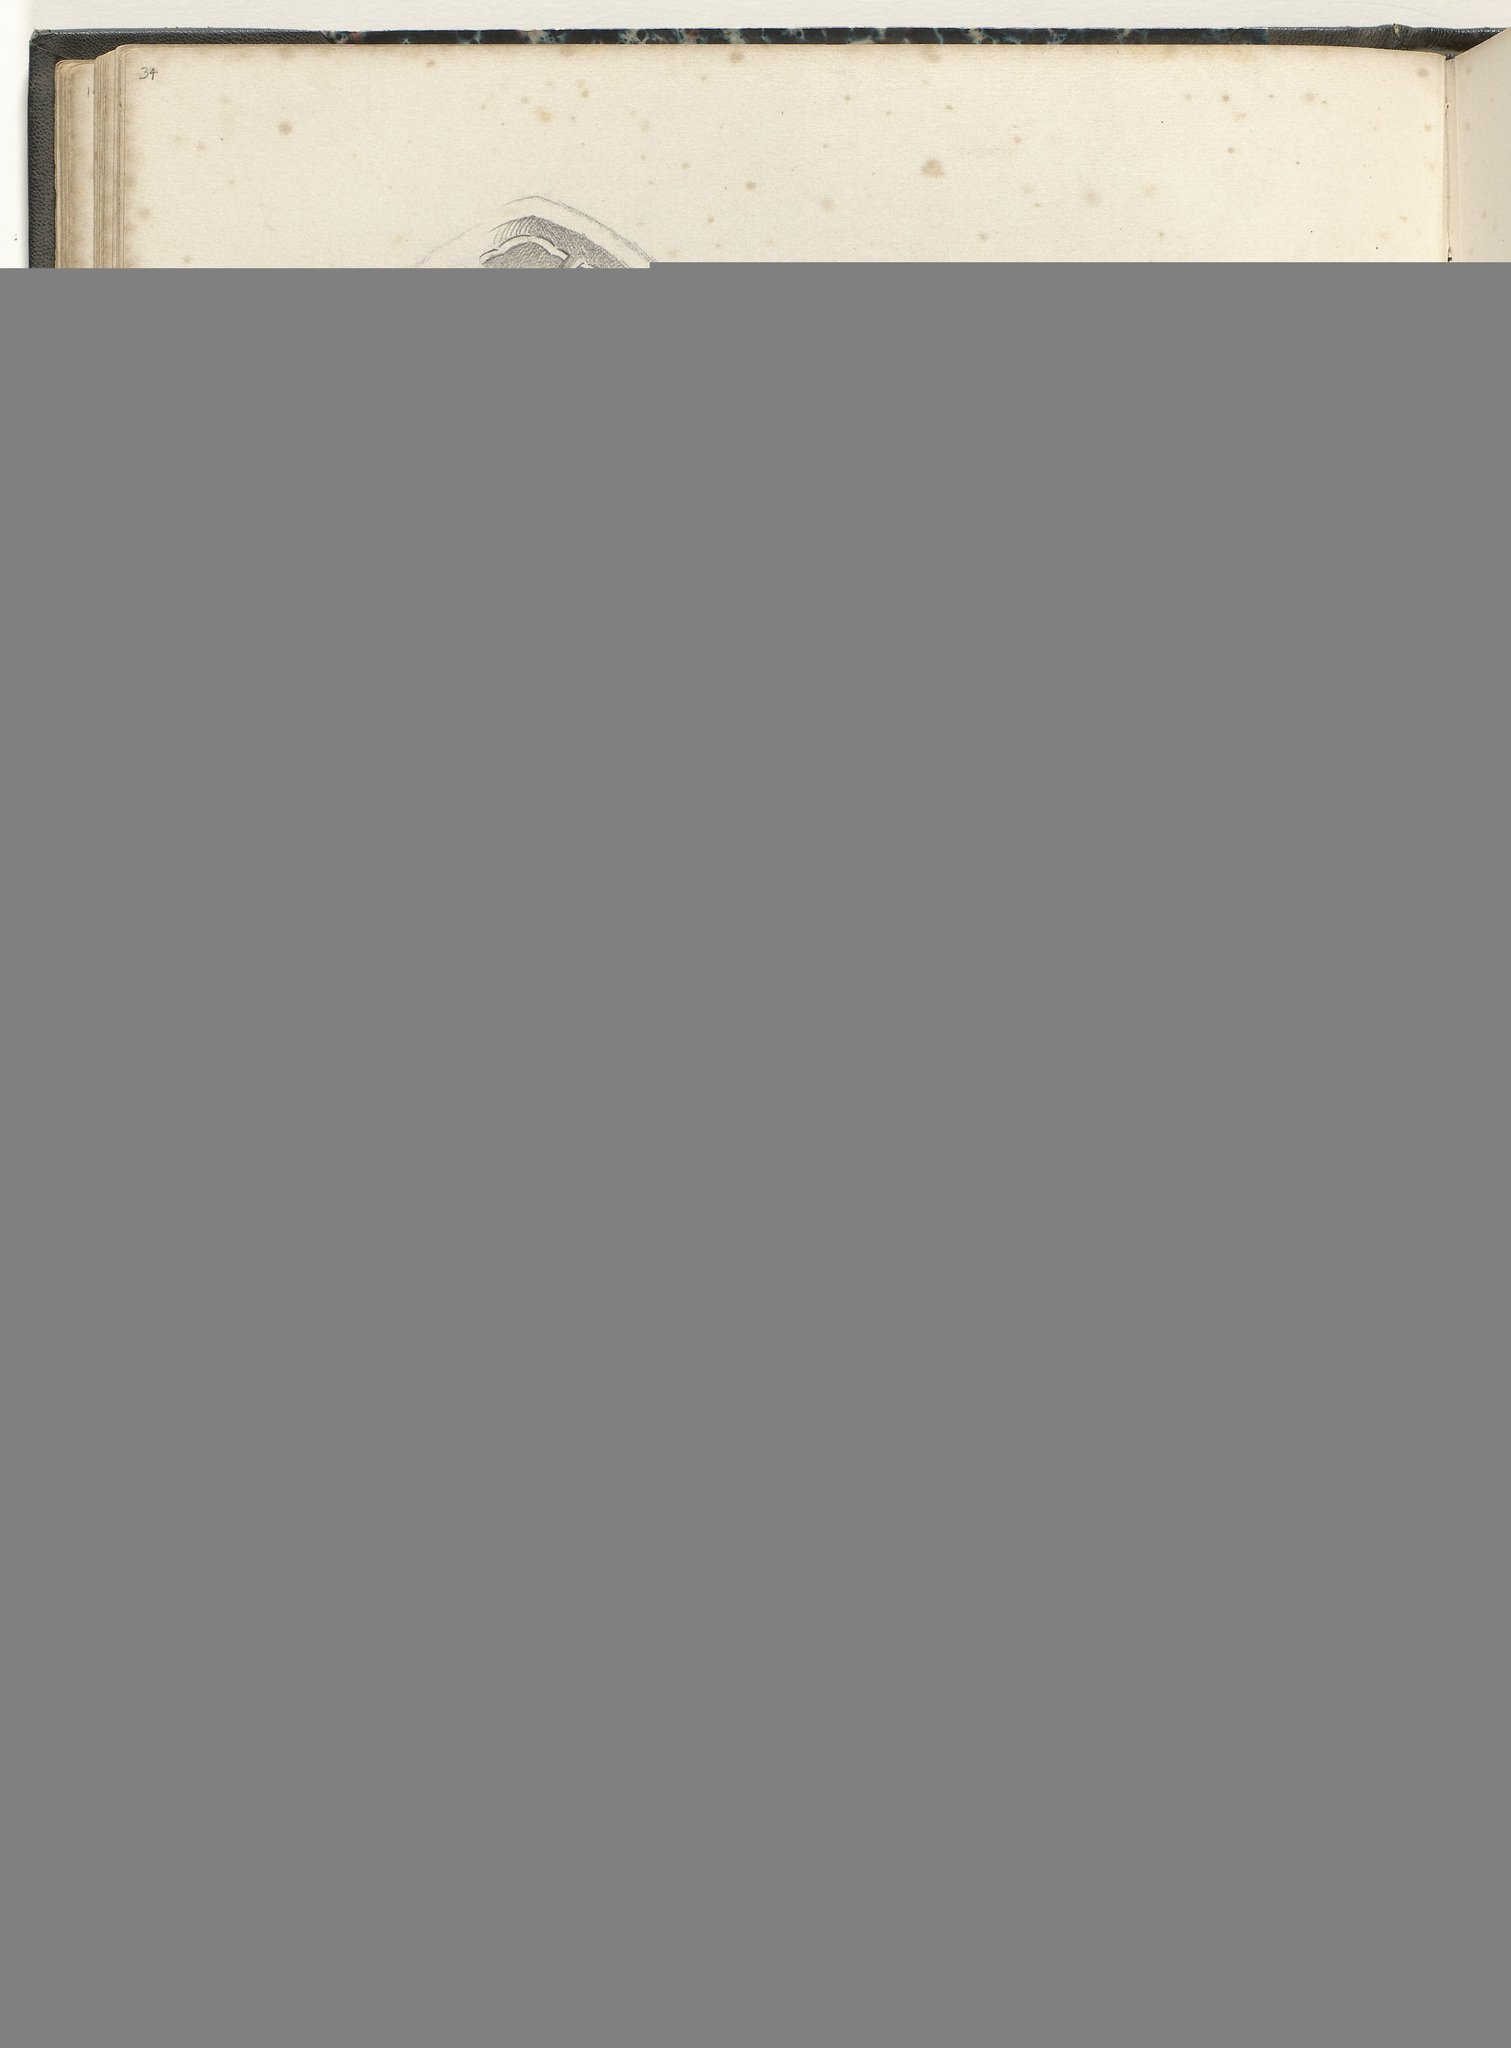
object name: drawing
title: Mascaron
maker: Anonymous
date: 1866-1900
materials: paper, pencil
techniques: drawing